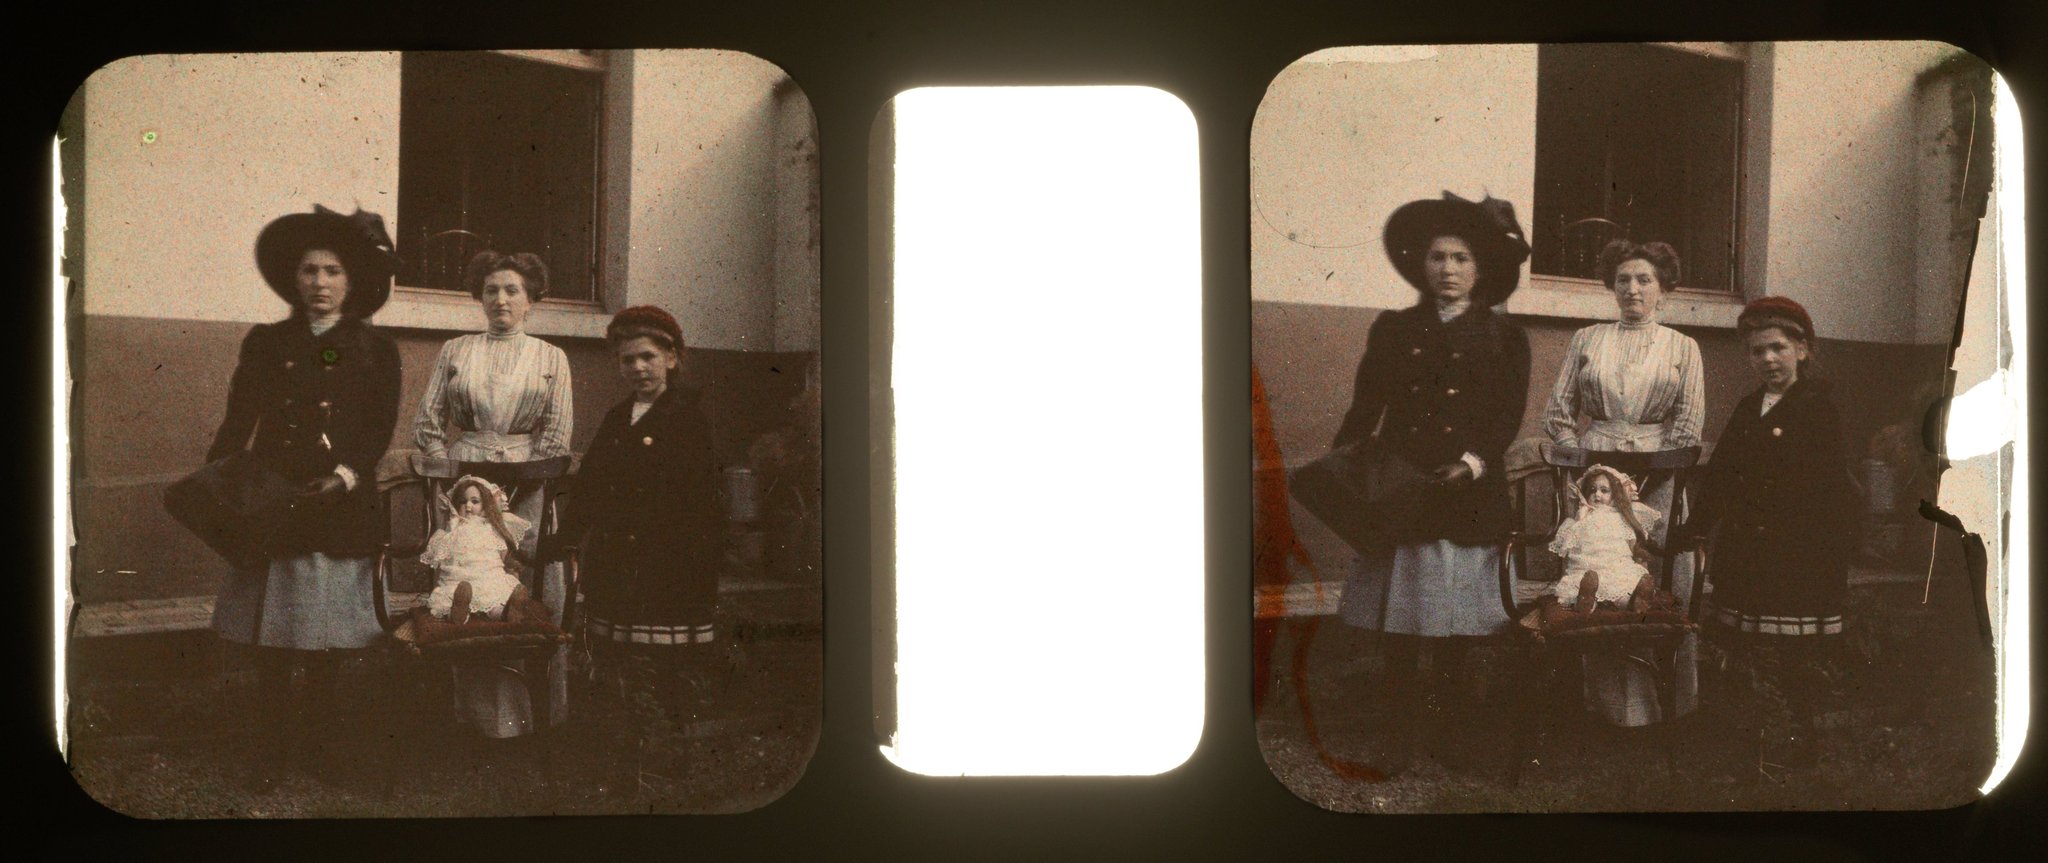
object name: stereoscopic photograph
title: Groepsportret van twee onbekende vrouwen, een meisje en een pop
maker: adolphe burdet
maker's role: fotograaf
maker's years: 1860-1940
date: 1907-1935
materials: glass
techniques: autochrome process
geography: netherlands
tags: historical persons not known by name - bb - woman, (playing with) dolls, netherlands